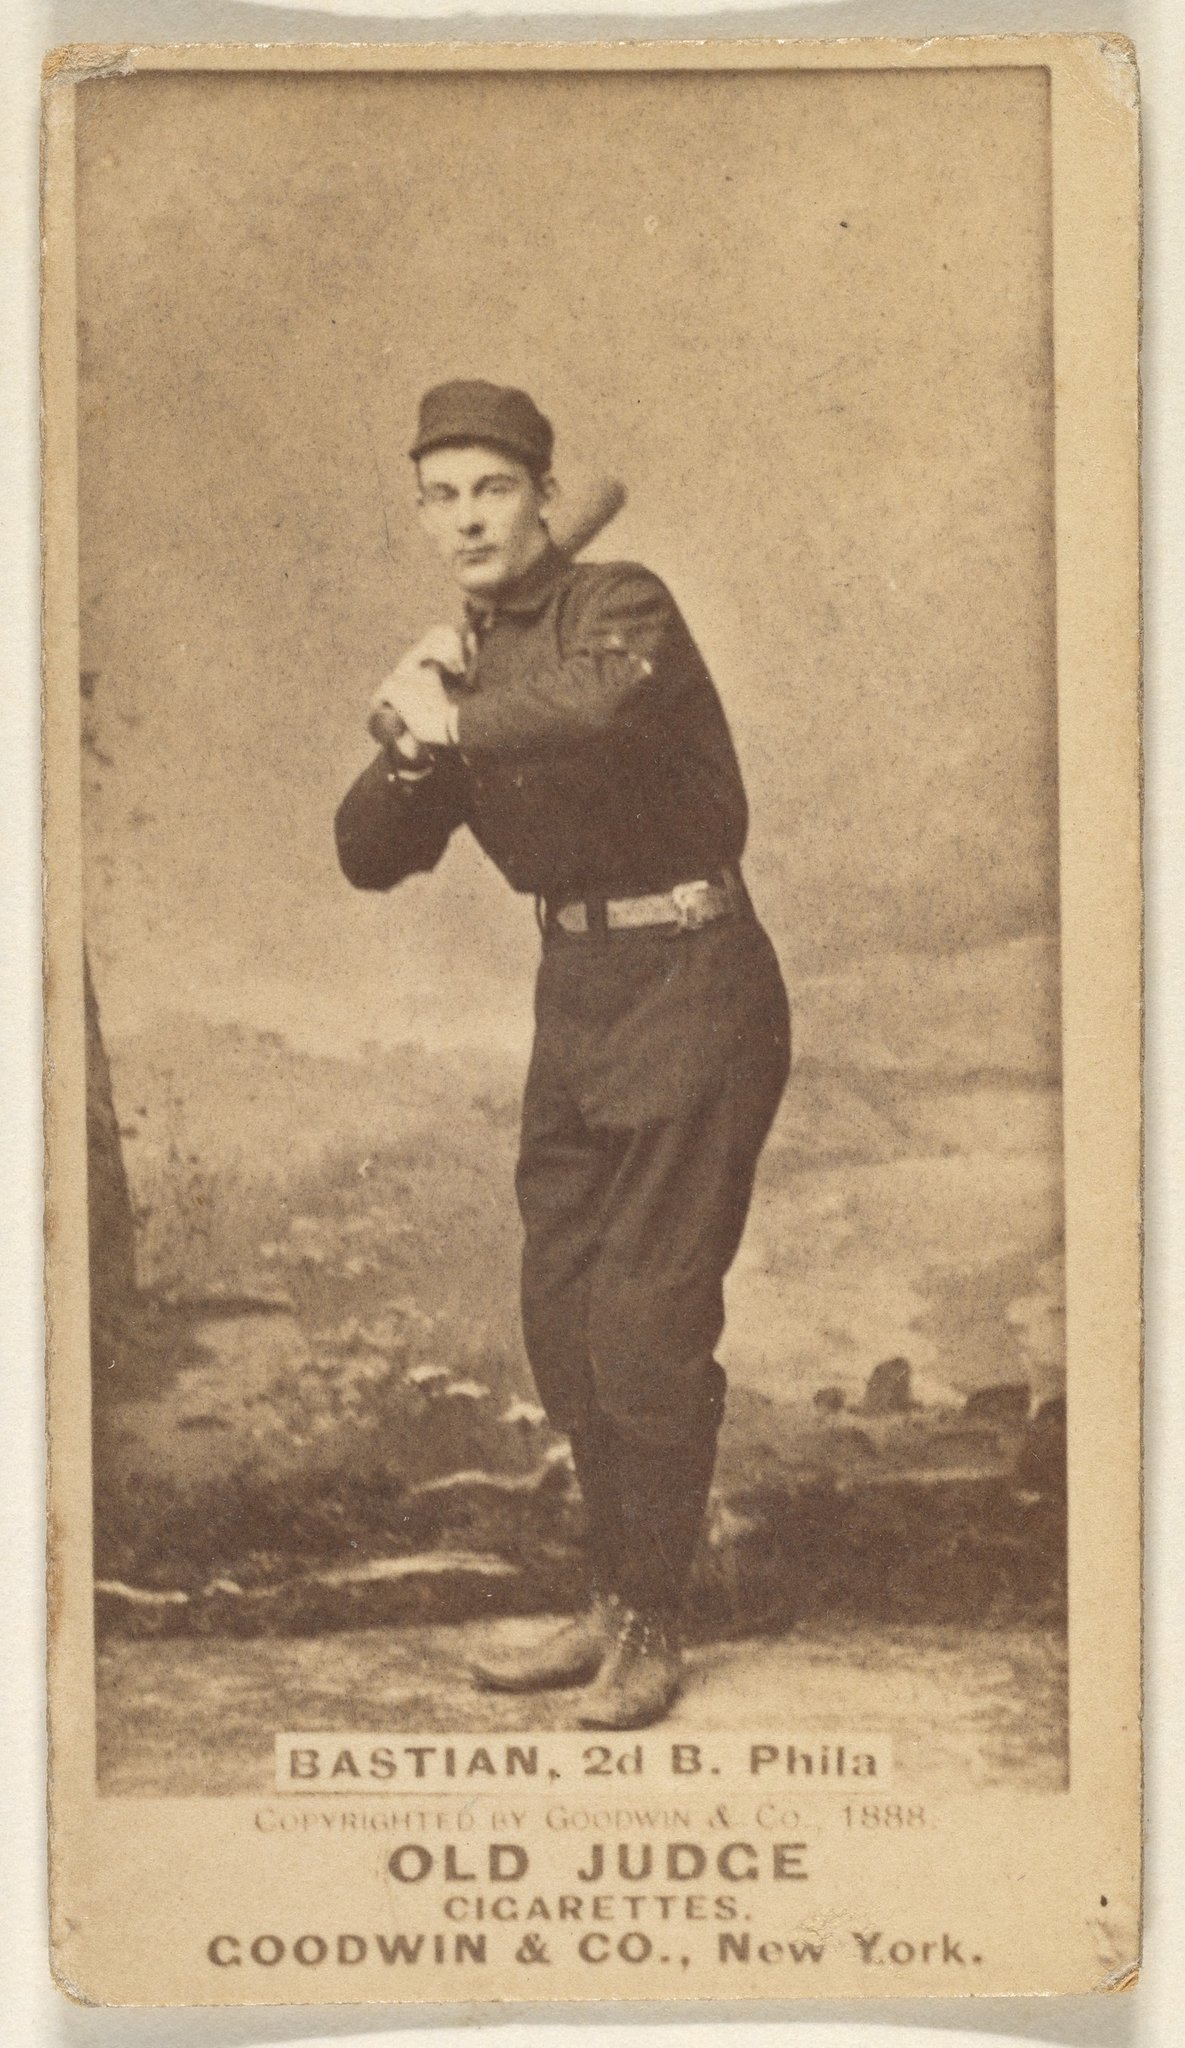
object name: baseball card, photograph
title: Charlie Bastian, 2nd Base, Philadelphia, from the Old Judge series (N172) for Old Judge Cigarettes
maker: goodwin & company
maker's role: publisher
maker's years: 1850-1950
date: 1888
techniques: albumen silver print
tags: men,portraits,baseball,athletes